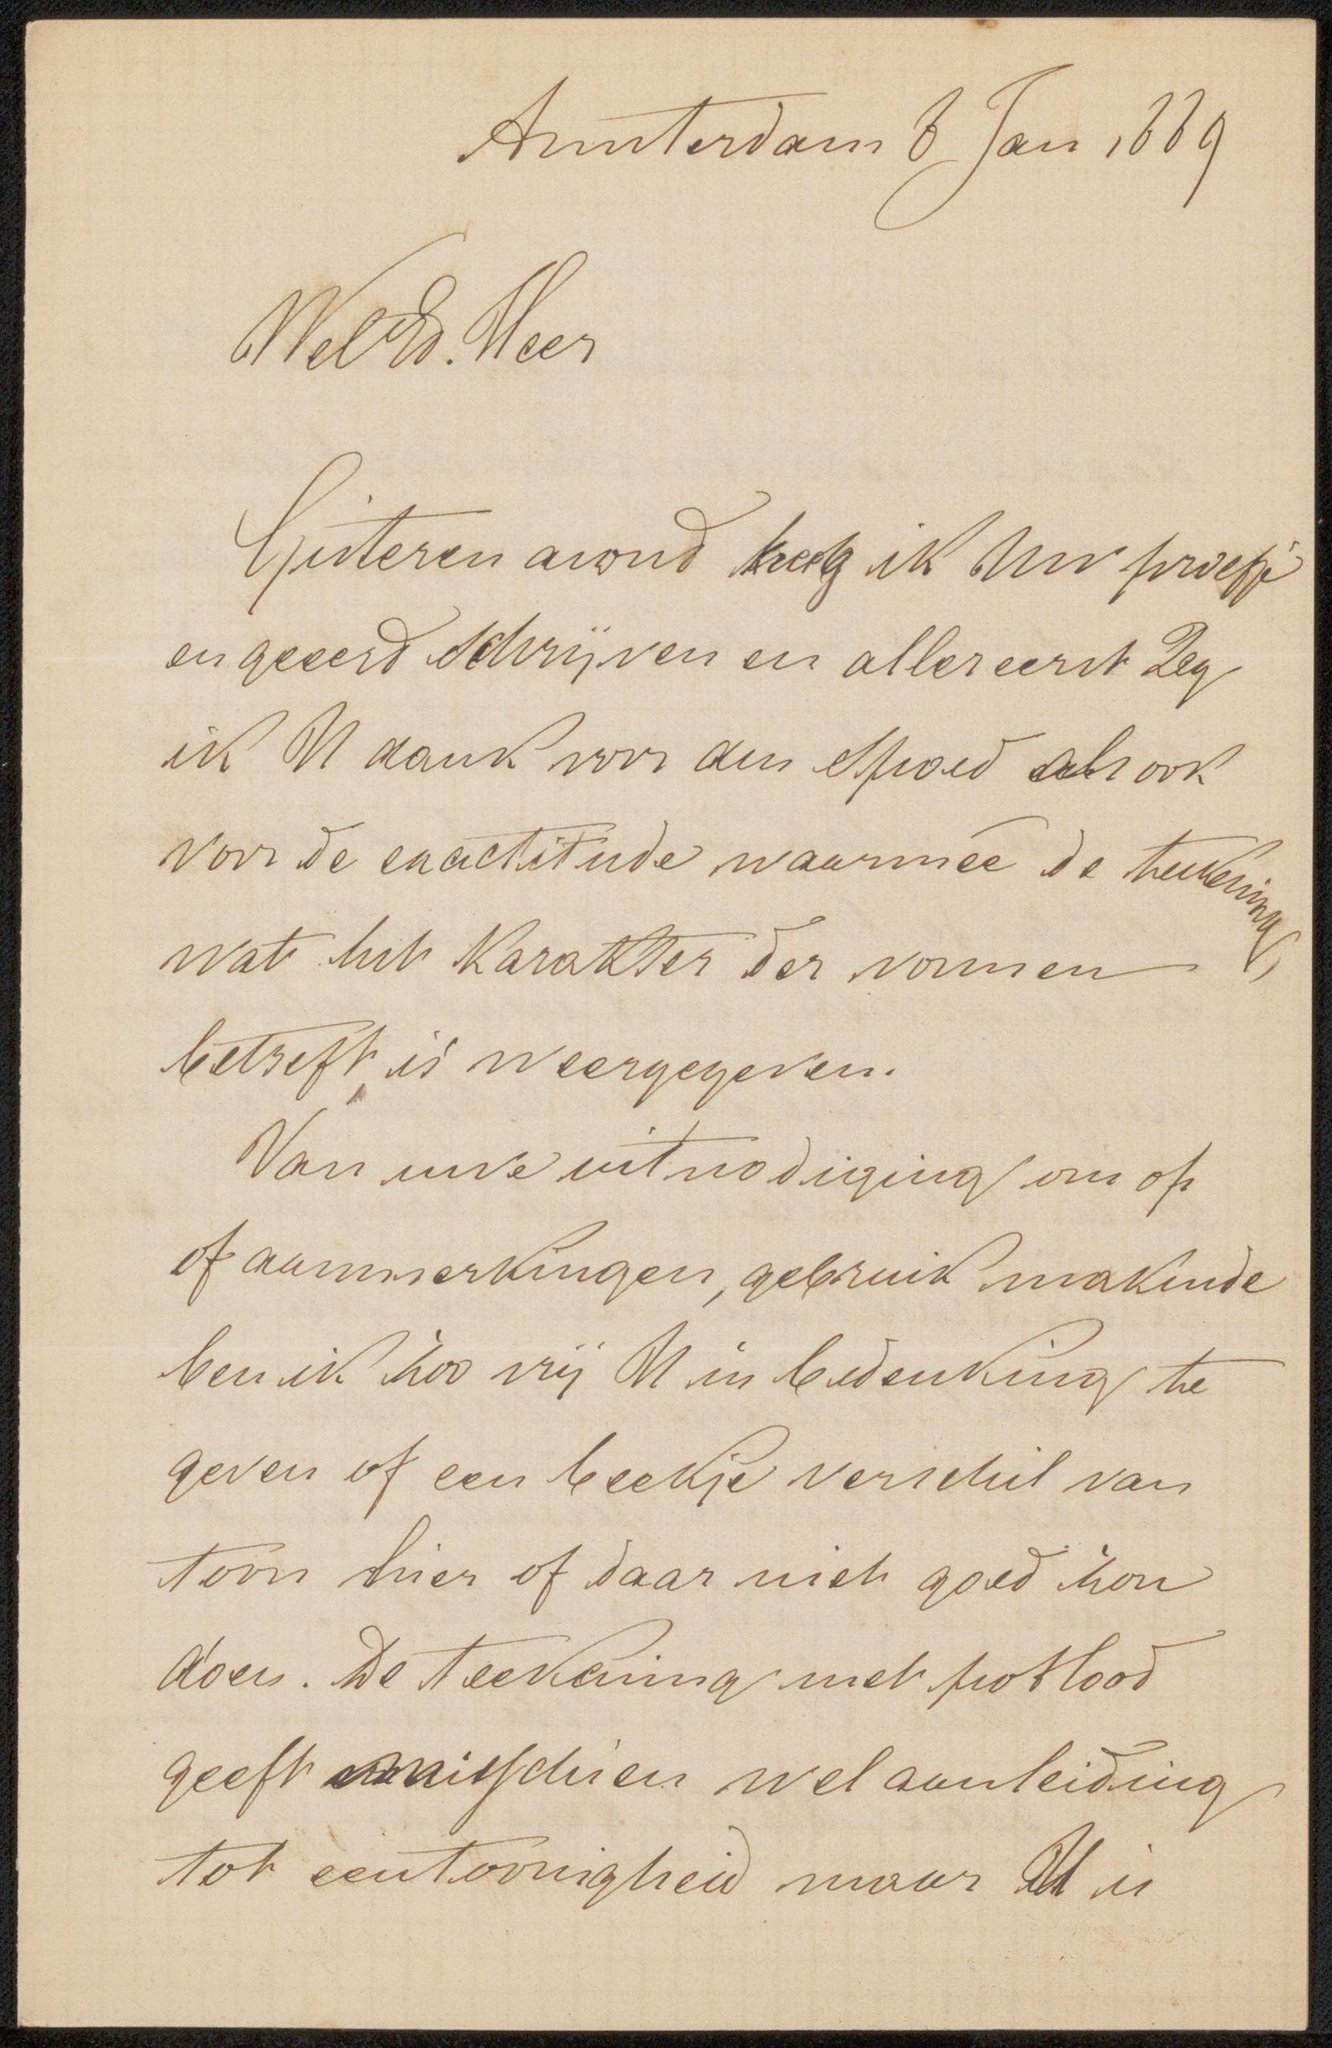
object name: letter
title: Brief aan Philip Zilcken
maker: edouard taurel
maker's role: draughtsman, print maker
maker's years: 1824-1892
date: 1889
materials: ink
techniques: pen, writing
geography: amsterdam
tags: the hague, painter, draughtsman, philip zilcken, drawing, the graphic arts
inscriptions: collector's mark: ‘RPK’